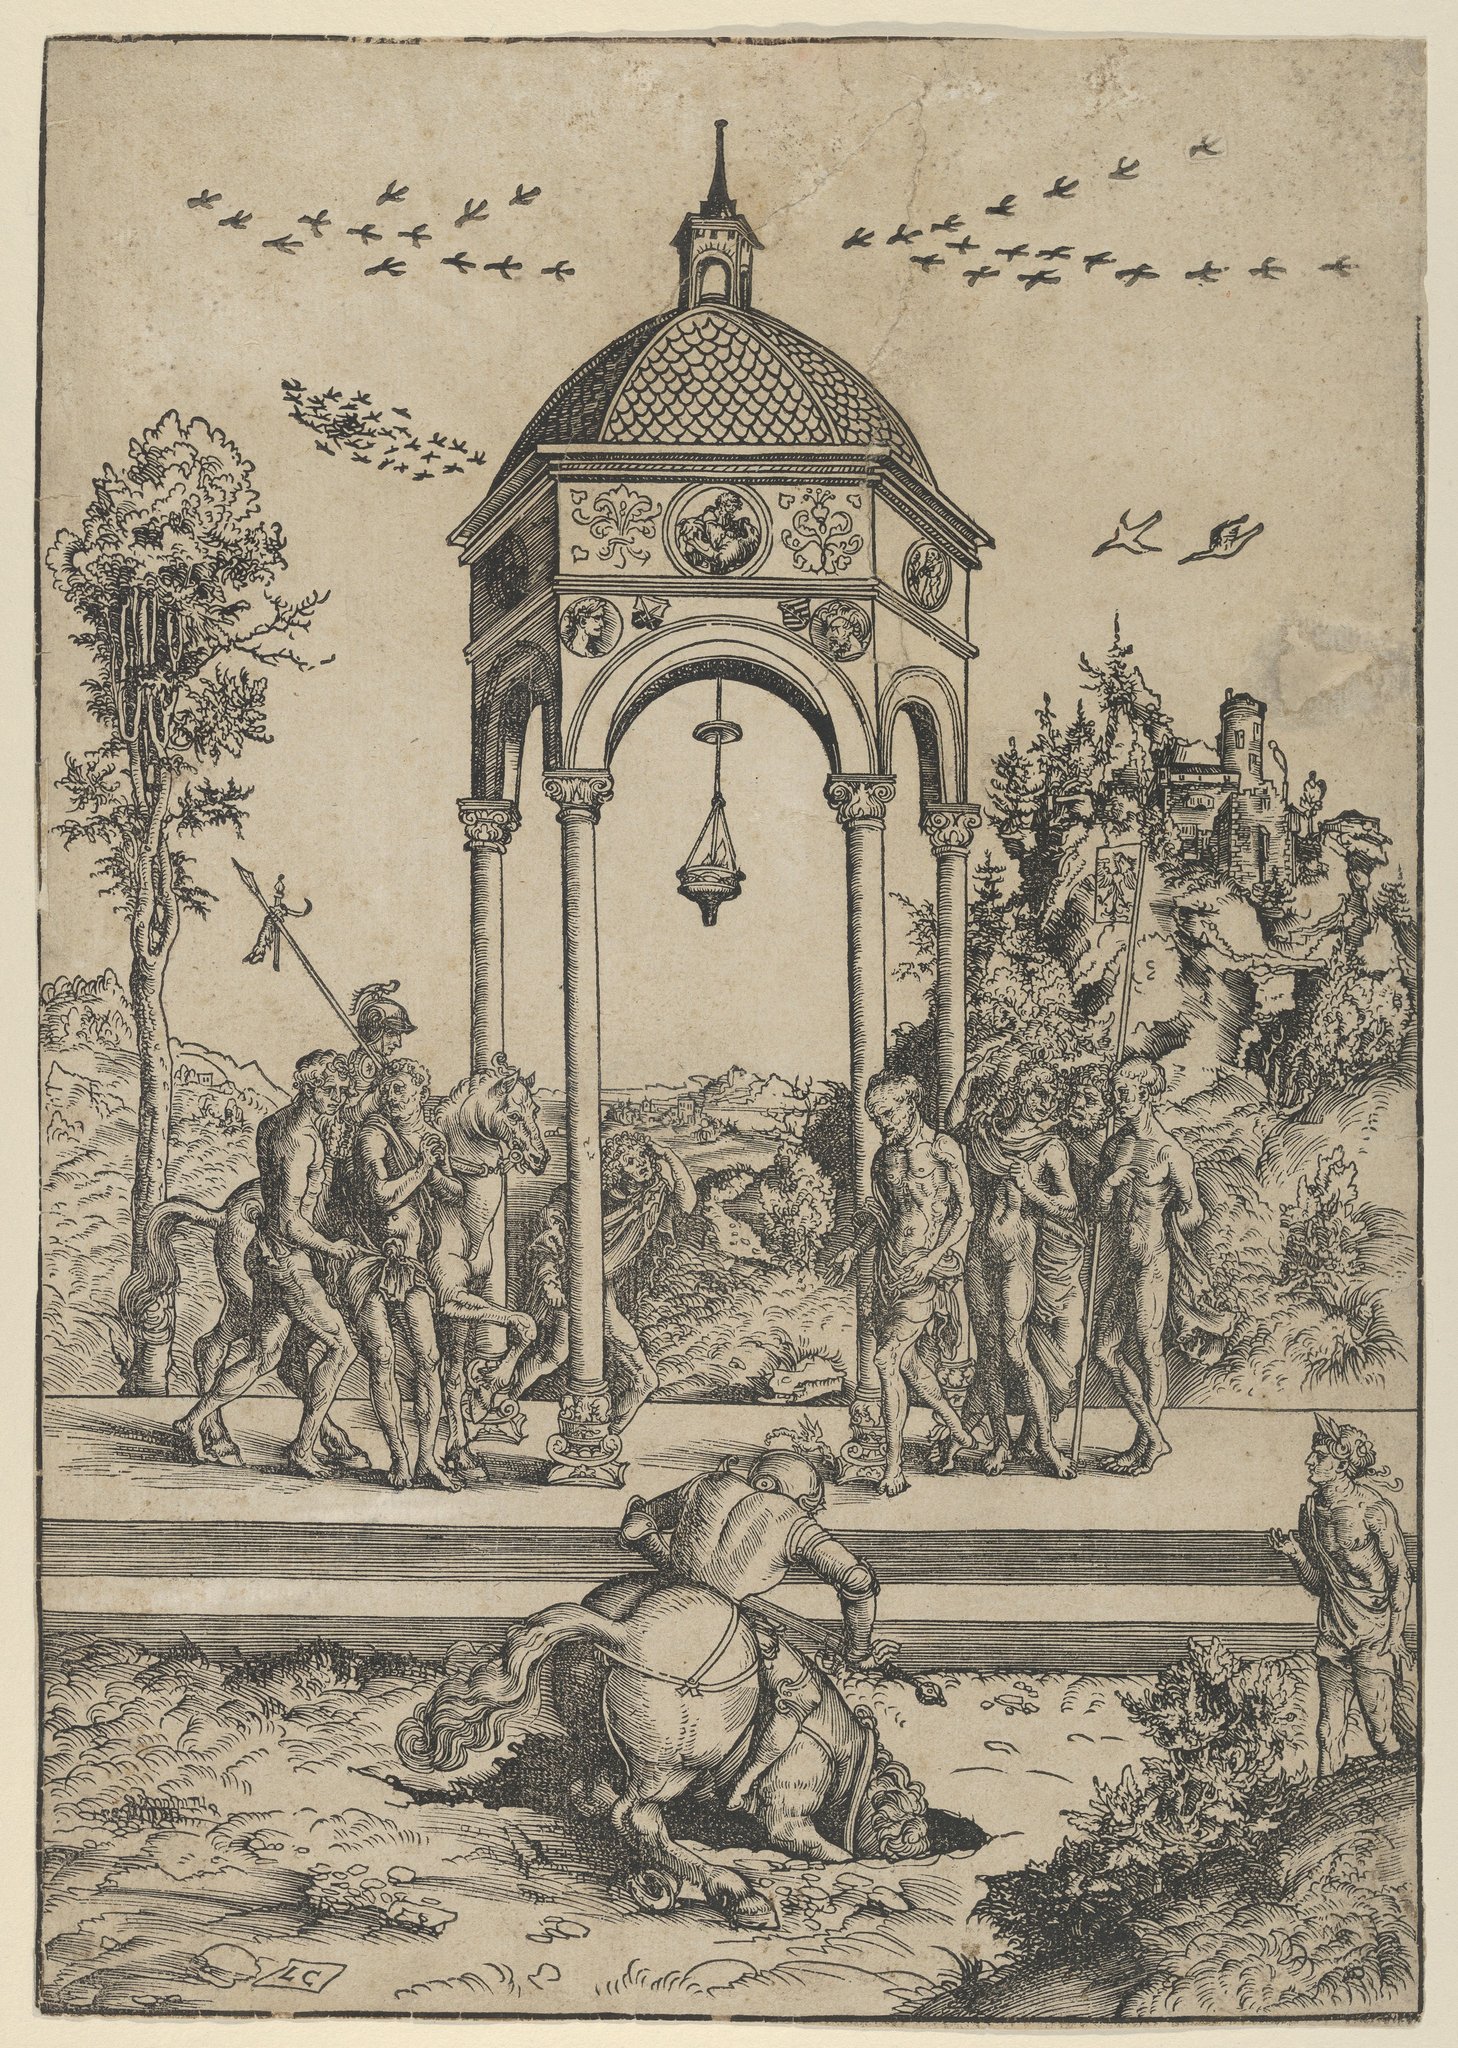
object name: print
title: Marcus Curtius Plunging Into the Chasm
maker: lucas cranach the elder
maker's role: artist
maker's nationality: german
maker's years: 1472-1553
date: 1472-1553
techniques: woodcut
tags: men,horses